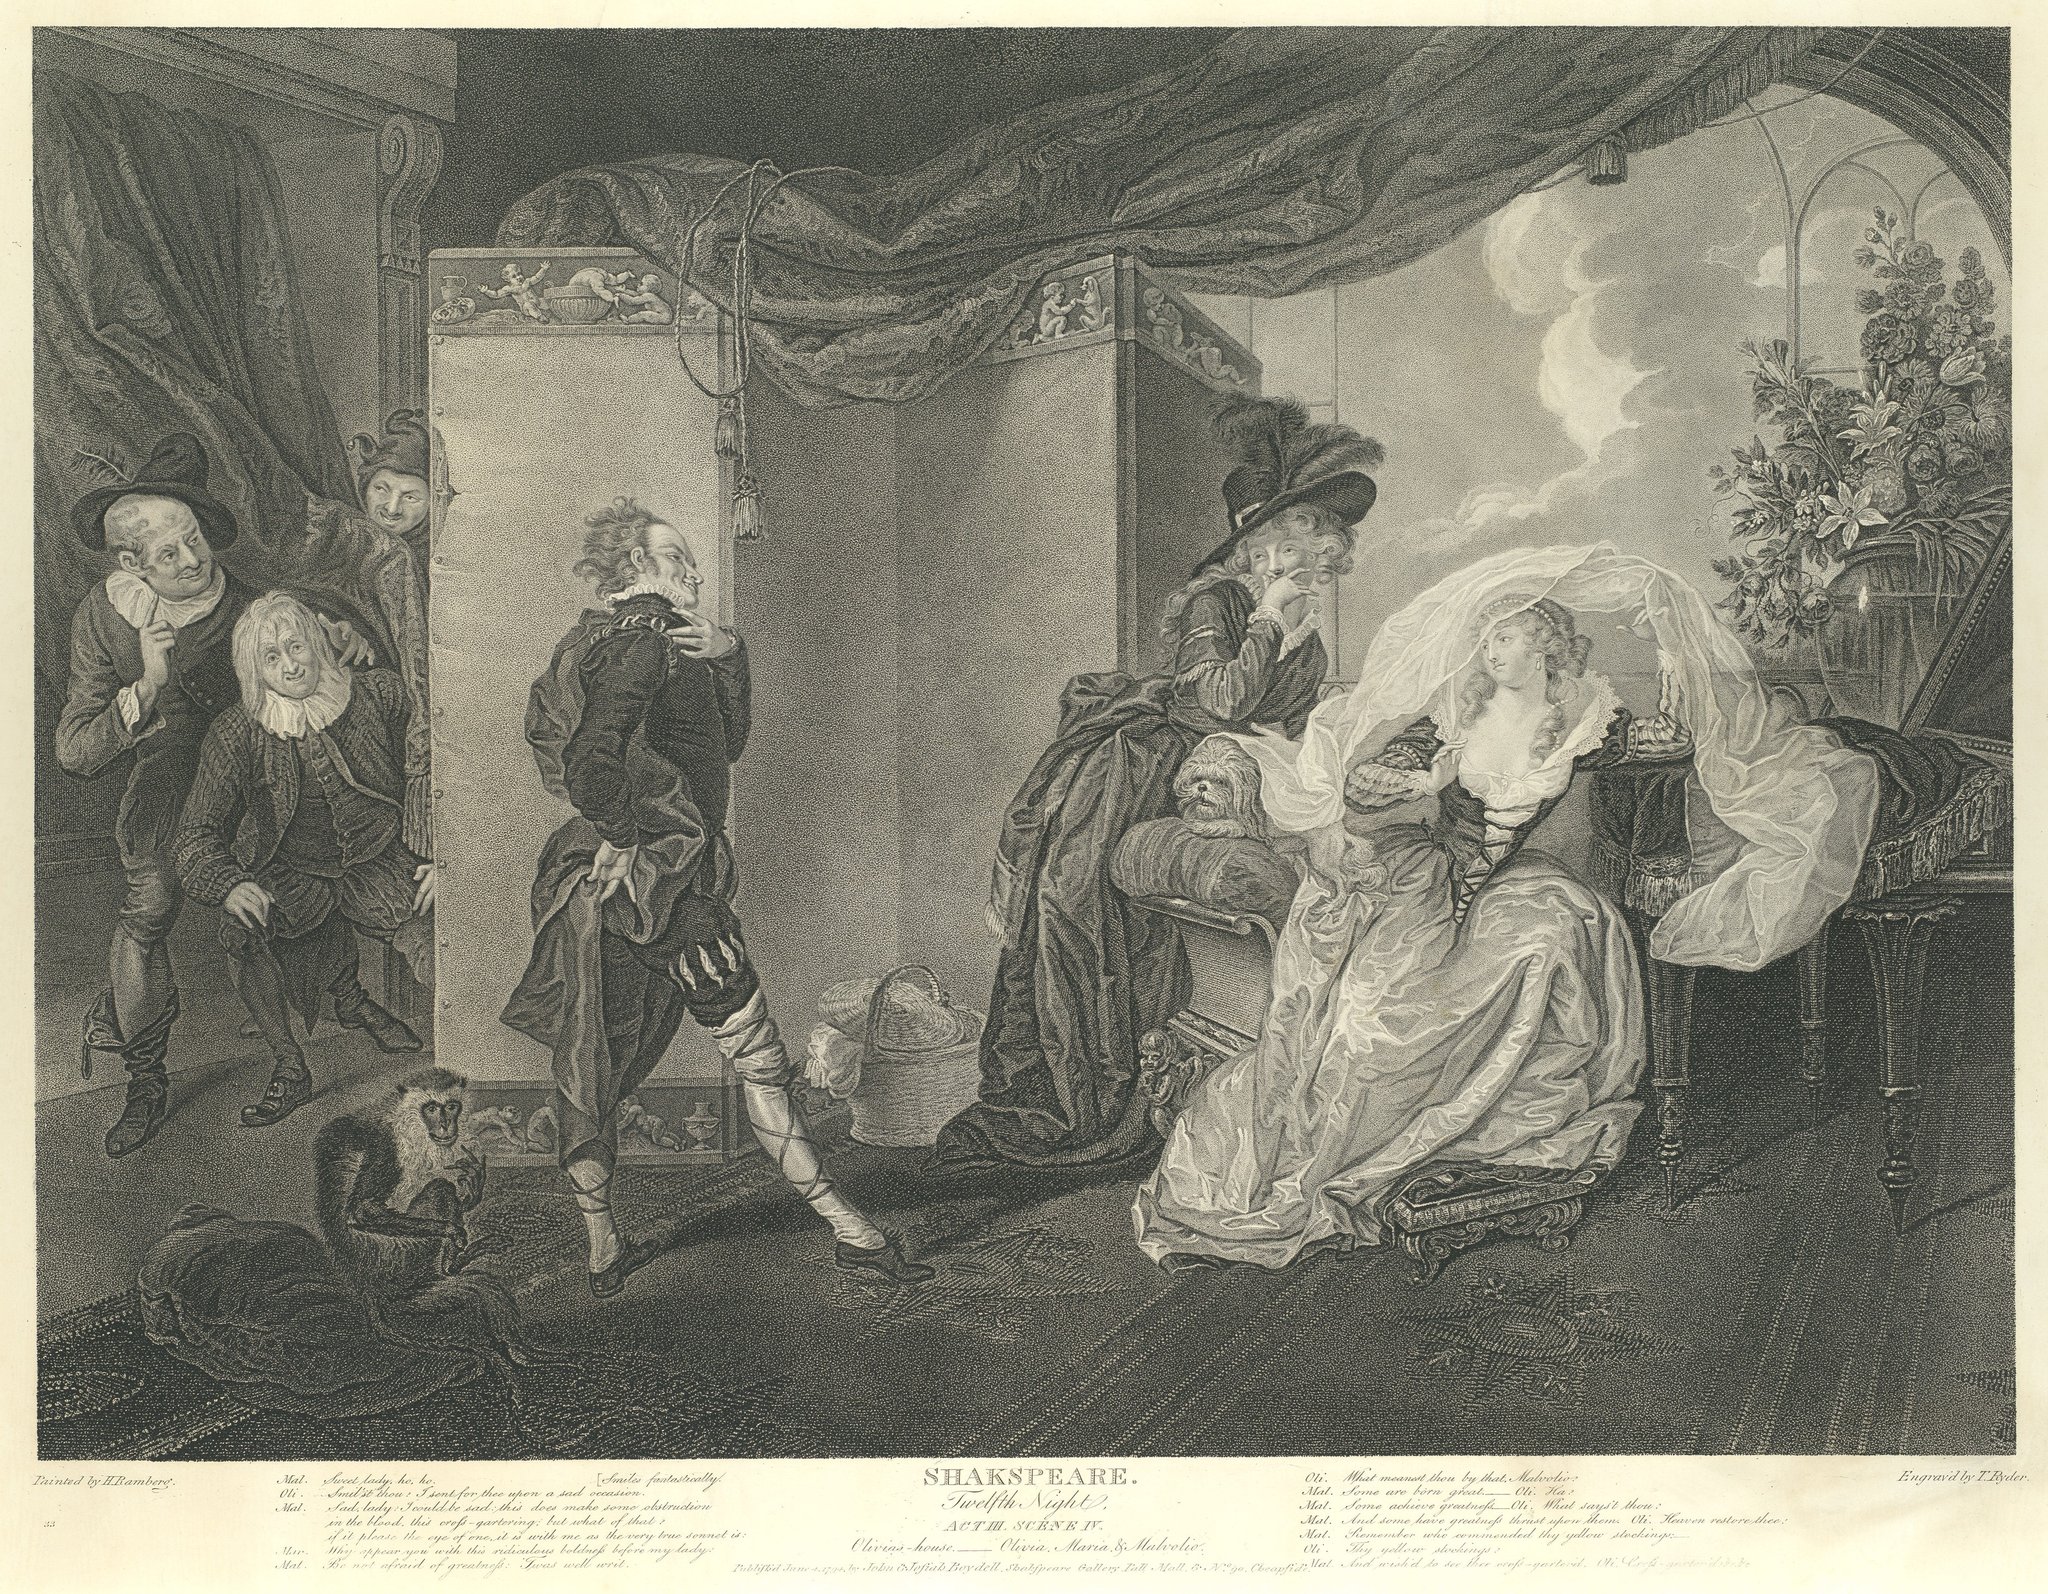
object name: print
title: Olivia's House - Olivia, Maria and Malvolio (Shakespeare, Twelfth Night, Act 3, Scene 4)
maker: thomas ryder i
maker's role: engraver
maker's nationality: british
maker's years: 1746-1810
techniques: engraving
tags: shakespeare,men,women,monkeys